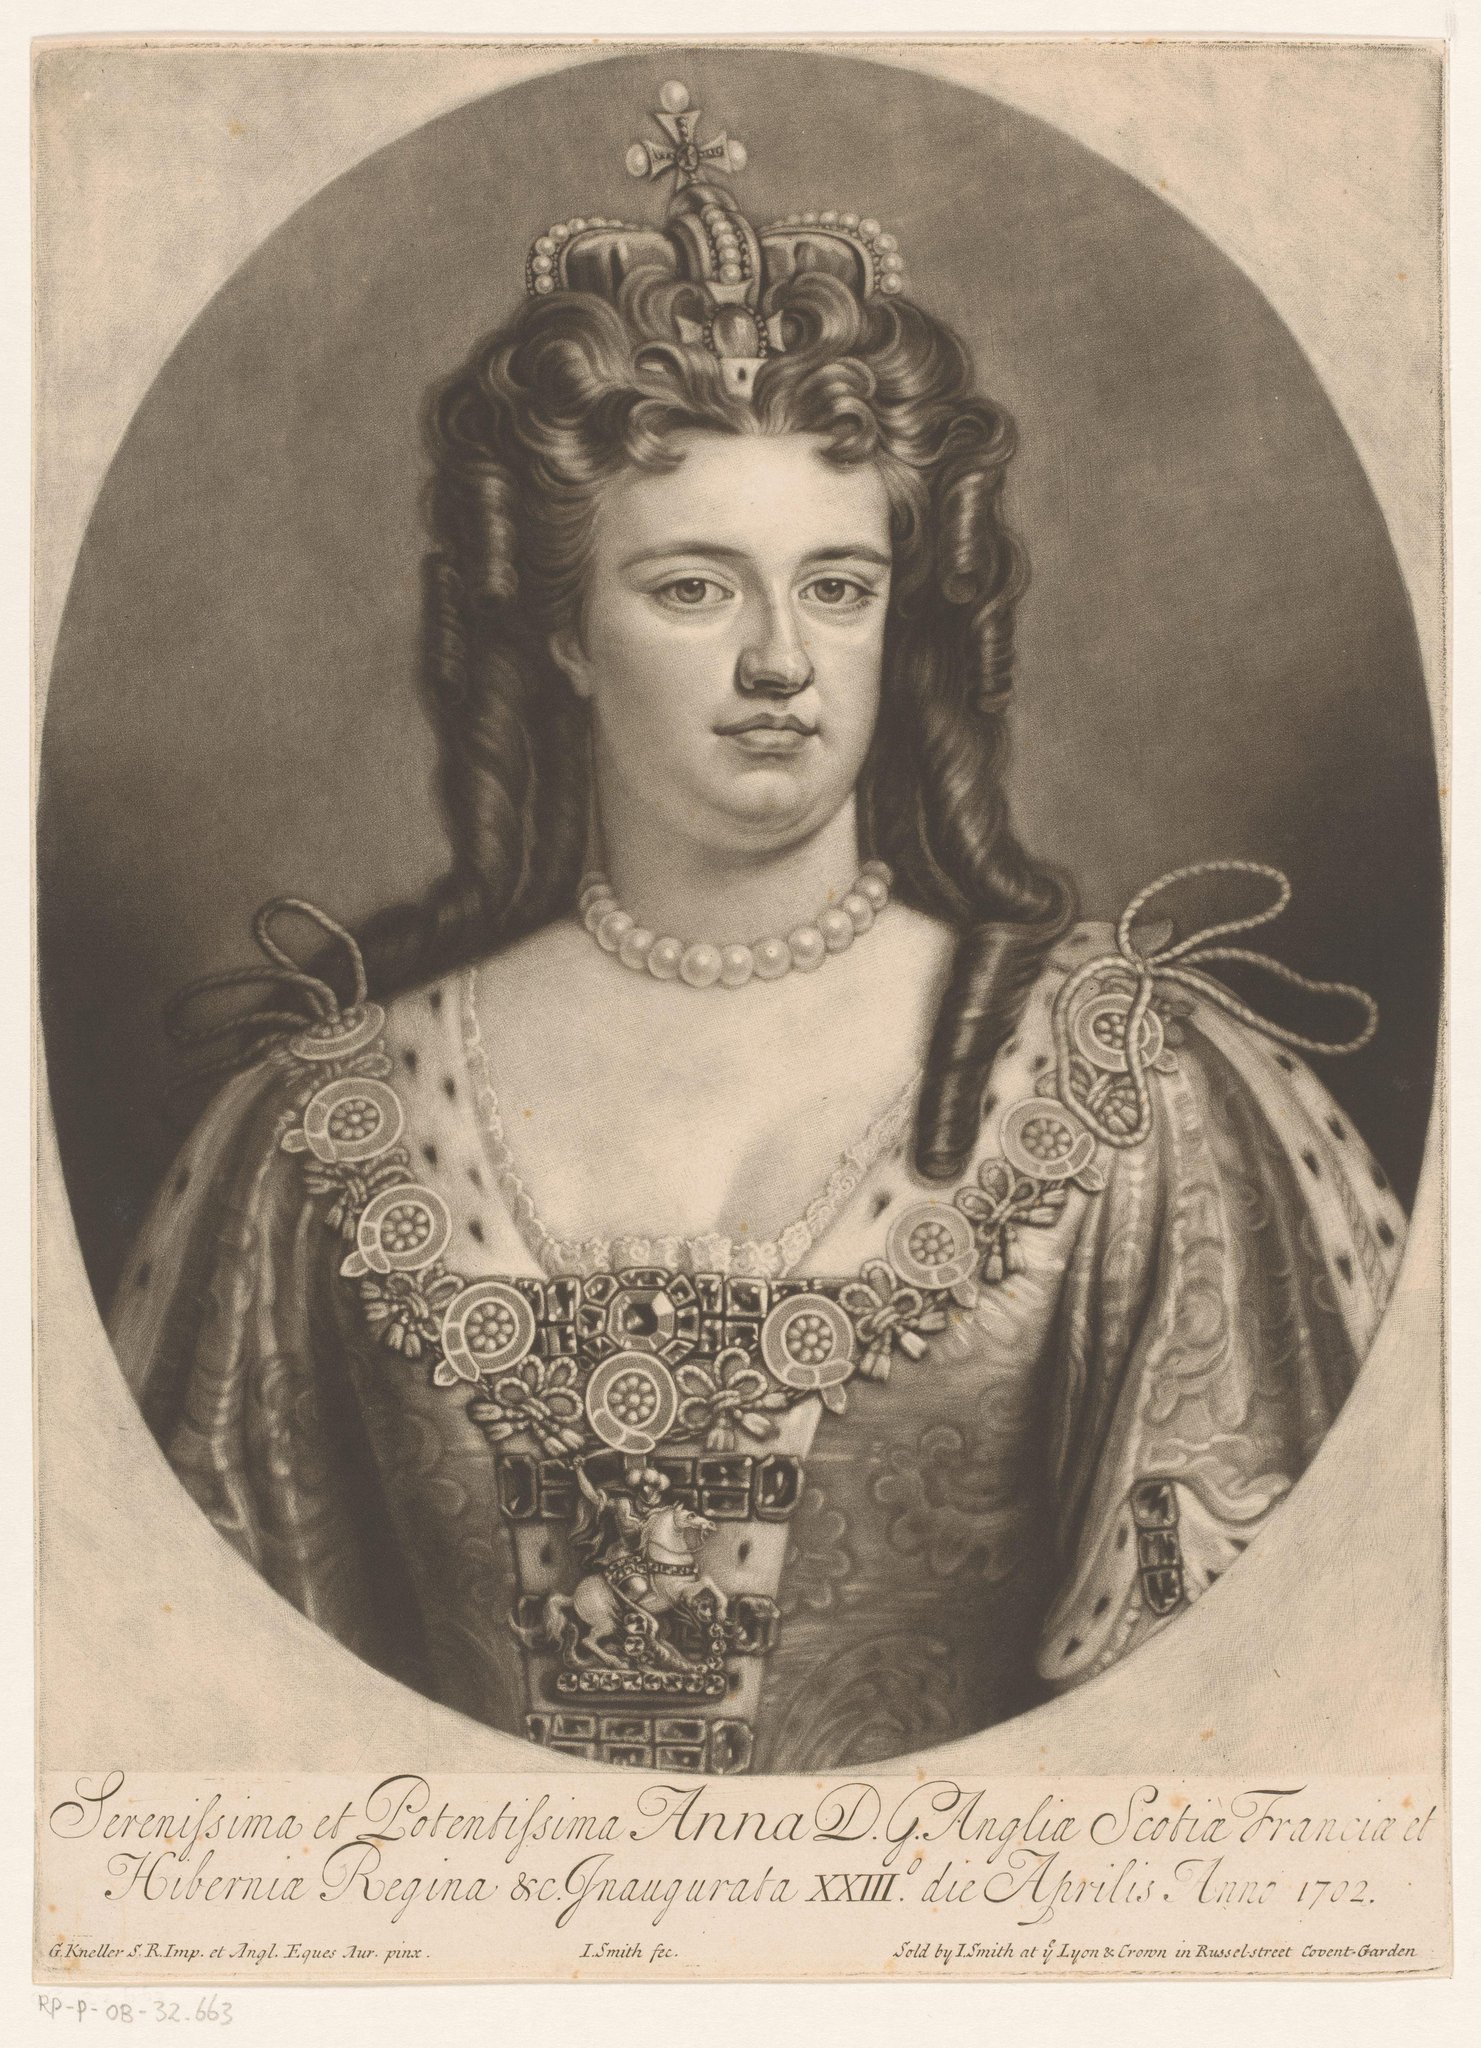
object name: print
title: Portret van Anna Stuart, koningin van Engeland en Schotland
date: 1702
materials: paper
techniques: mezzotint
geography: london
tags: anna stuart (koningin van engeland en schotland), historical persons, queen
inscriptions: collector's mark: Lugt 240